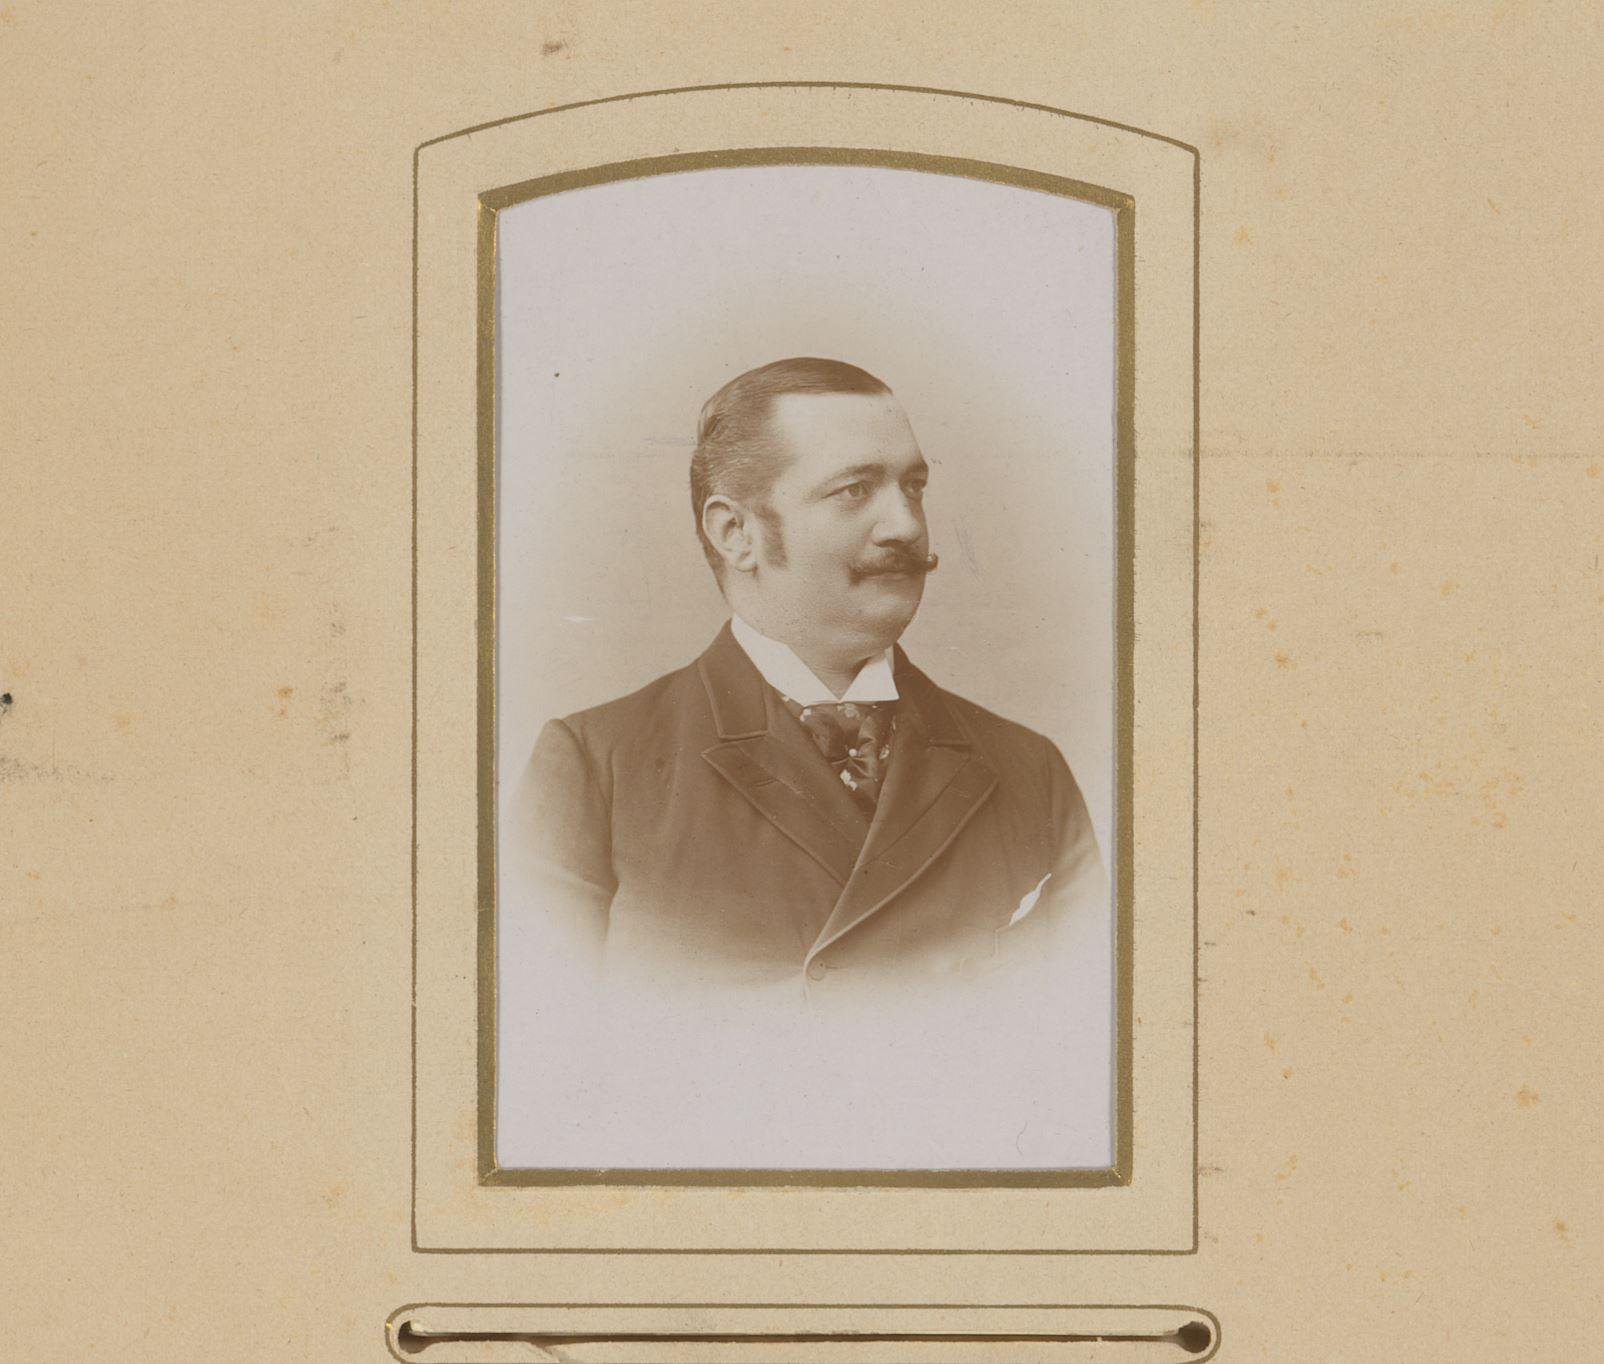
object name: carte de visite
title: Portret van een man met snor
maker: edouard fabronius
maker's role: fotograaf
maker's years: 1847-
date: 1891-1908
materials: cardboard, photographic support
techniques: collodion silver print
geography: brussels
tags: moustache, historical persons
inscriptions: inscription: ‘Fabronius/ Photographe/ 11/ Rue Neuve,/ Bruxelles./ Les clichés sont conservés.’